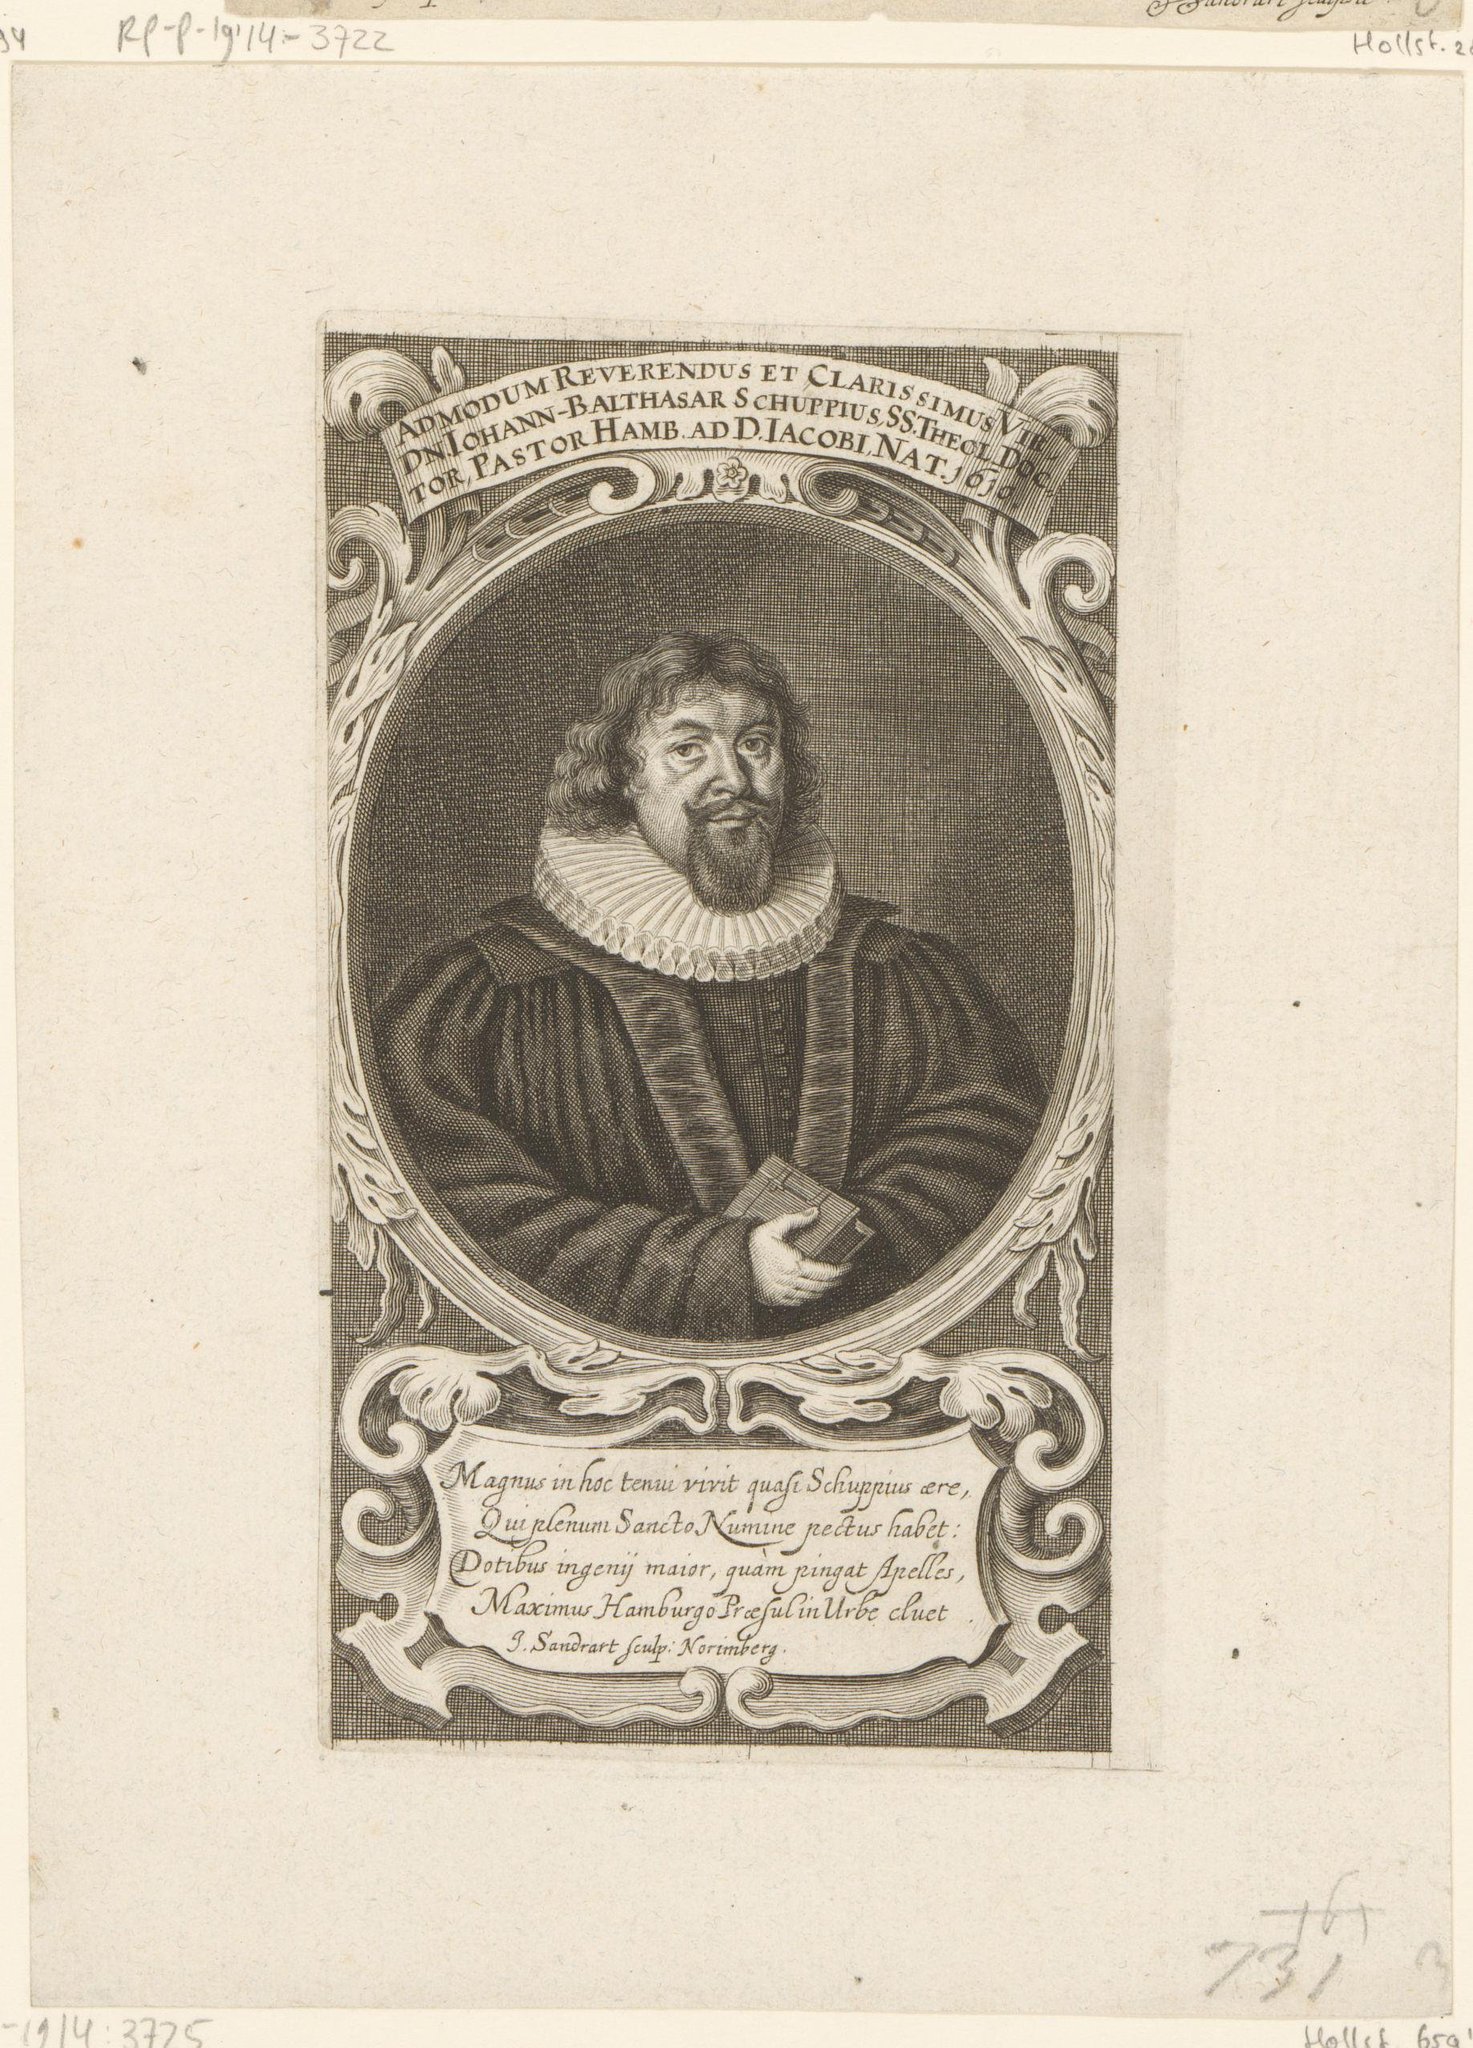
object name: print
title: Portret van Johann Balthasar Schupp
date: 1663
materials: paper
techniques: etching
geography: nuremberg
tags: theologian, historical persons, book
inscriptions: collector's mark: Lugt 2228